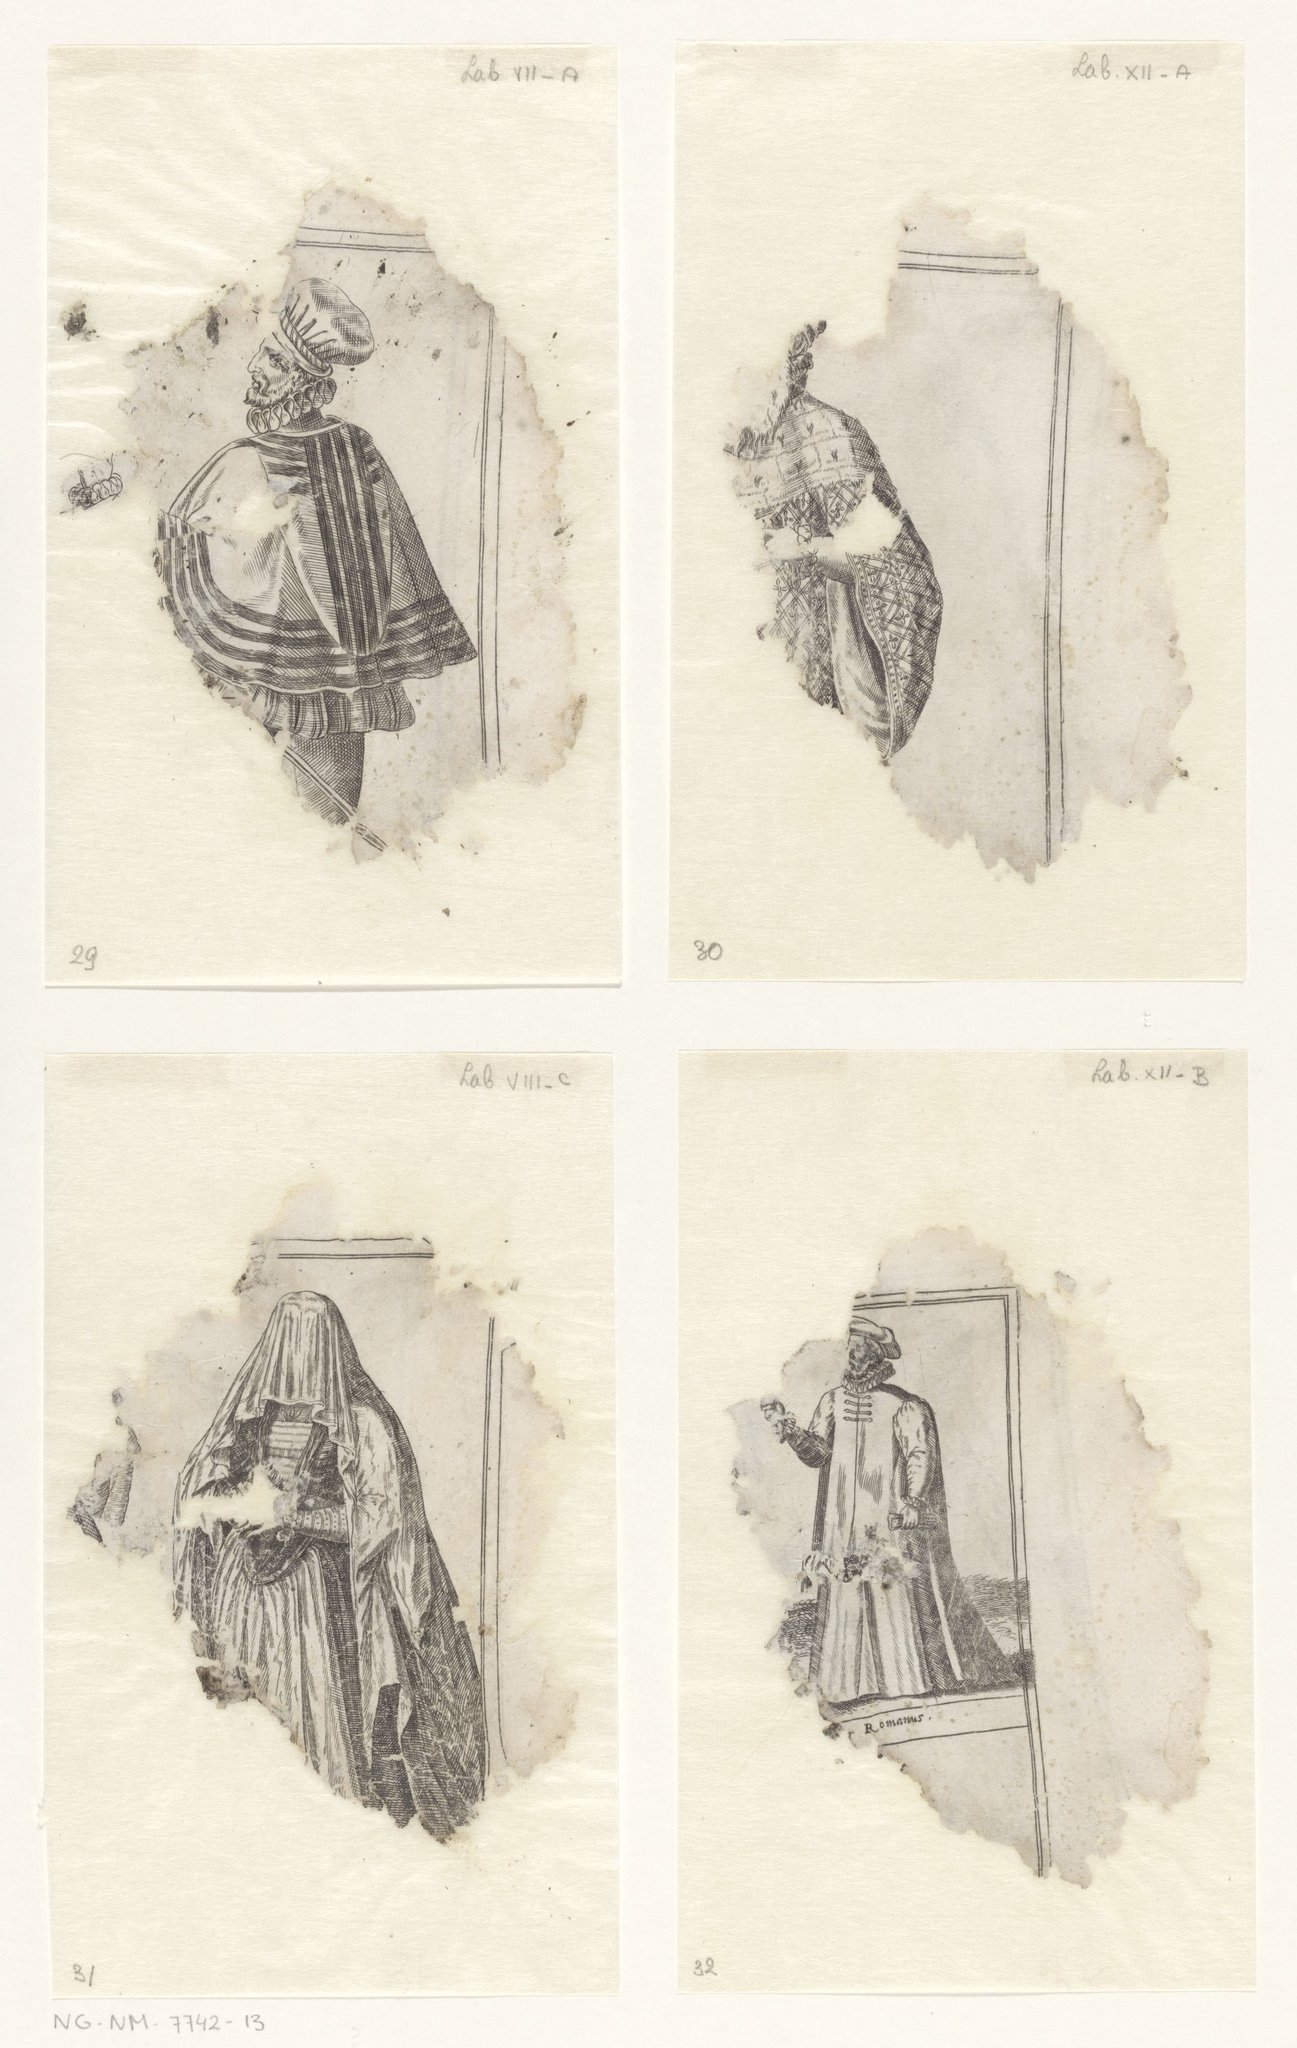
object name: print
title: Fragmenten van prenten met wereldlijke en geestelijke klederdrachten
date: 1581-1596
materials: paper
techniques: engraving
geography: cologne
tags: clothes, costume (+ women's clothes), clothes, costume (+ men's clothes)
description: De prenten in de Nova Zembla collectie zijn tijdens een expeditie van Willem Barendsz en Jacob van Heemskerk in 1596-1597 noodgedwongen in het winterkamp, het ‘Behouden Huis’, op het eiland achtergelaten. De prenten waren in één of meerdere stapels als handelswaar meegenomen vanuit Amsterdam. Bijna drie eeuwen later, in 1871, keerde de Noor Elling Carlsen terug naar Nova Zembla en vond daar de restanten van het ‘Behouden Huis, inclusief een groot deel van de inventaris. Een deel van de prenten, in de vorm van aaneengekoekte kluiten, werd toen ook teruggevonden. De papierkluiten waren soms op meerdere plekken gebroken. Tussen 1975-1979 zijn de prenten van elkaar gescheiden. Dit leverde in totaal ca. 1000 fragmenten van ca. 400 afdrukken van ca. 150 verschillende prenten op. Voor zover mogelijk zijn de fragmenten samengevoegd en zijn de prenten gereconstrueerd.